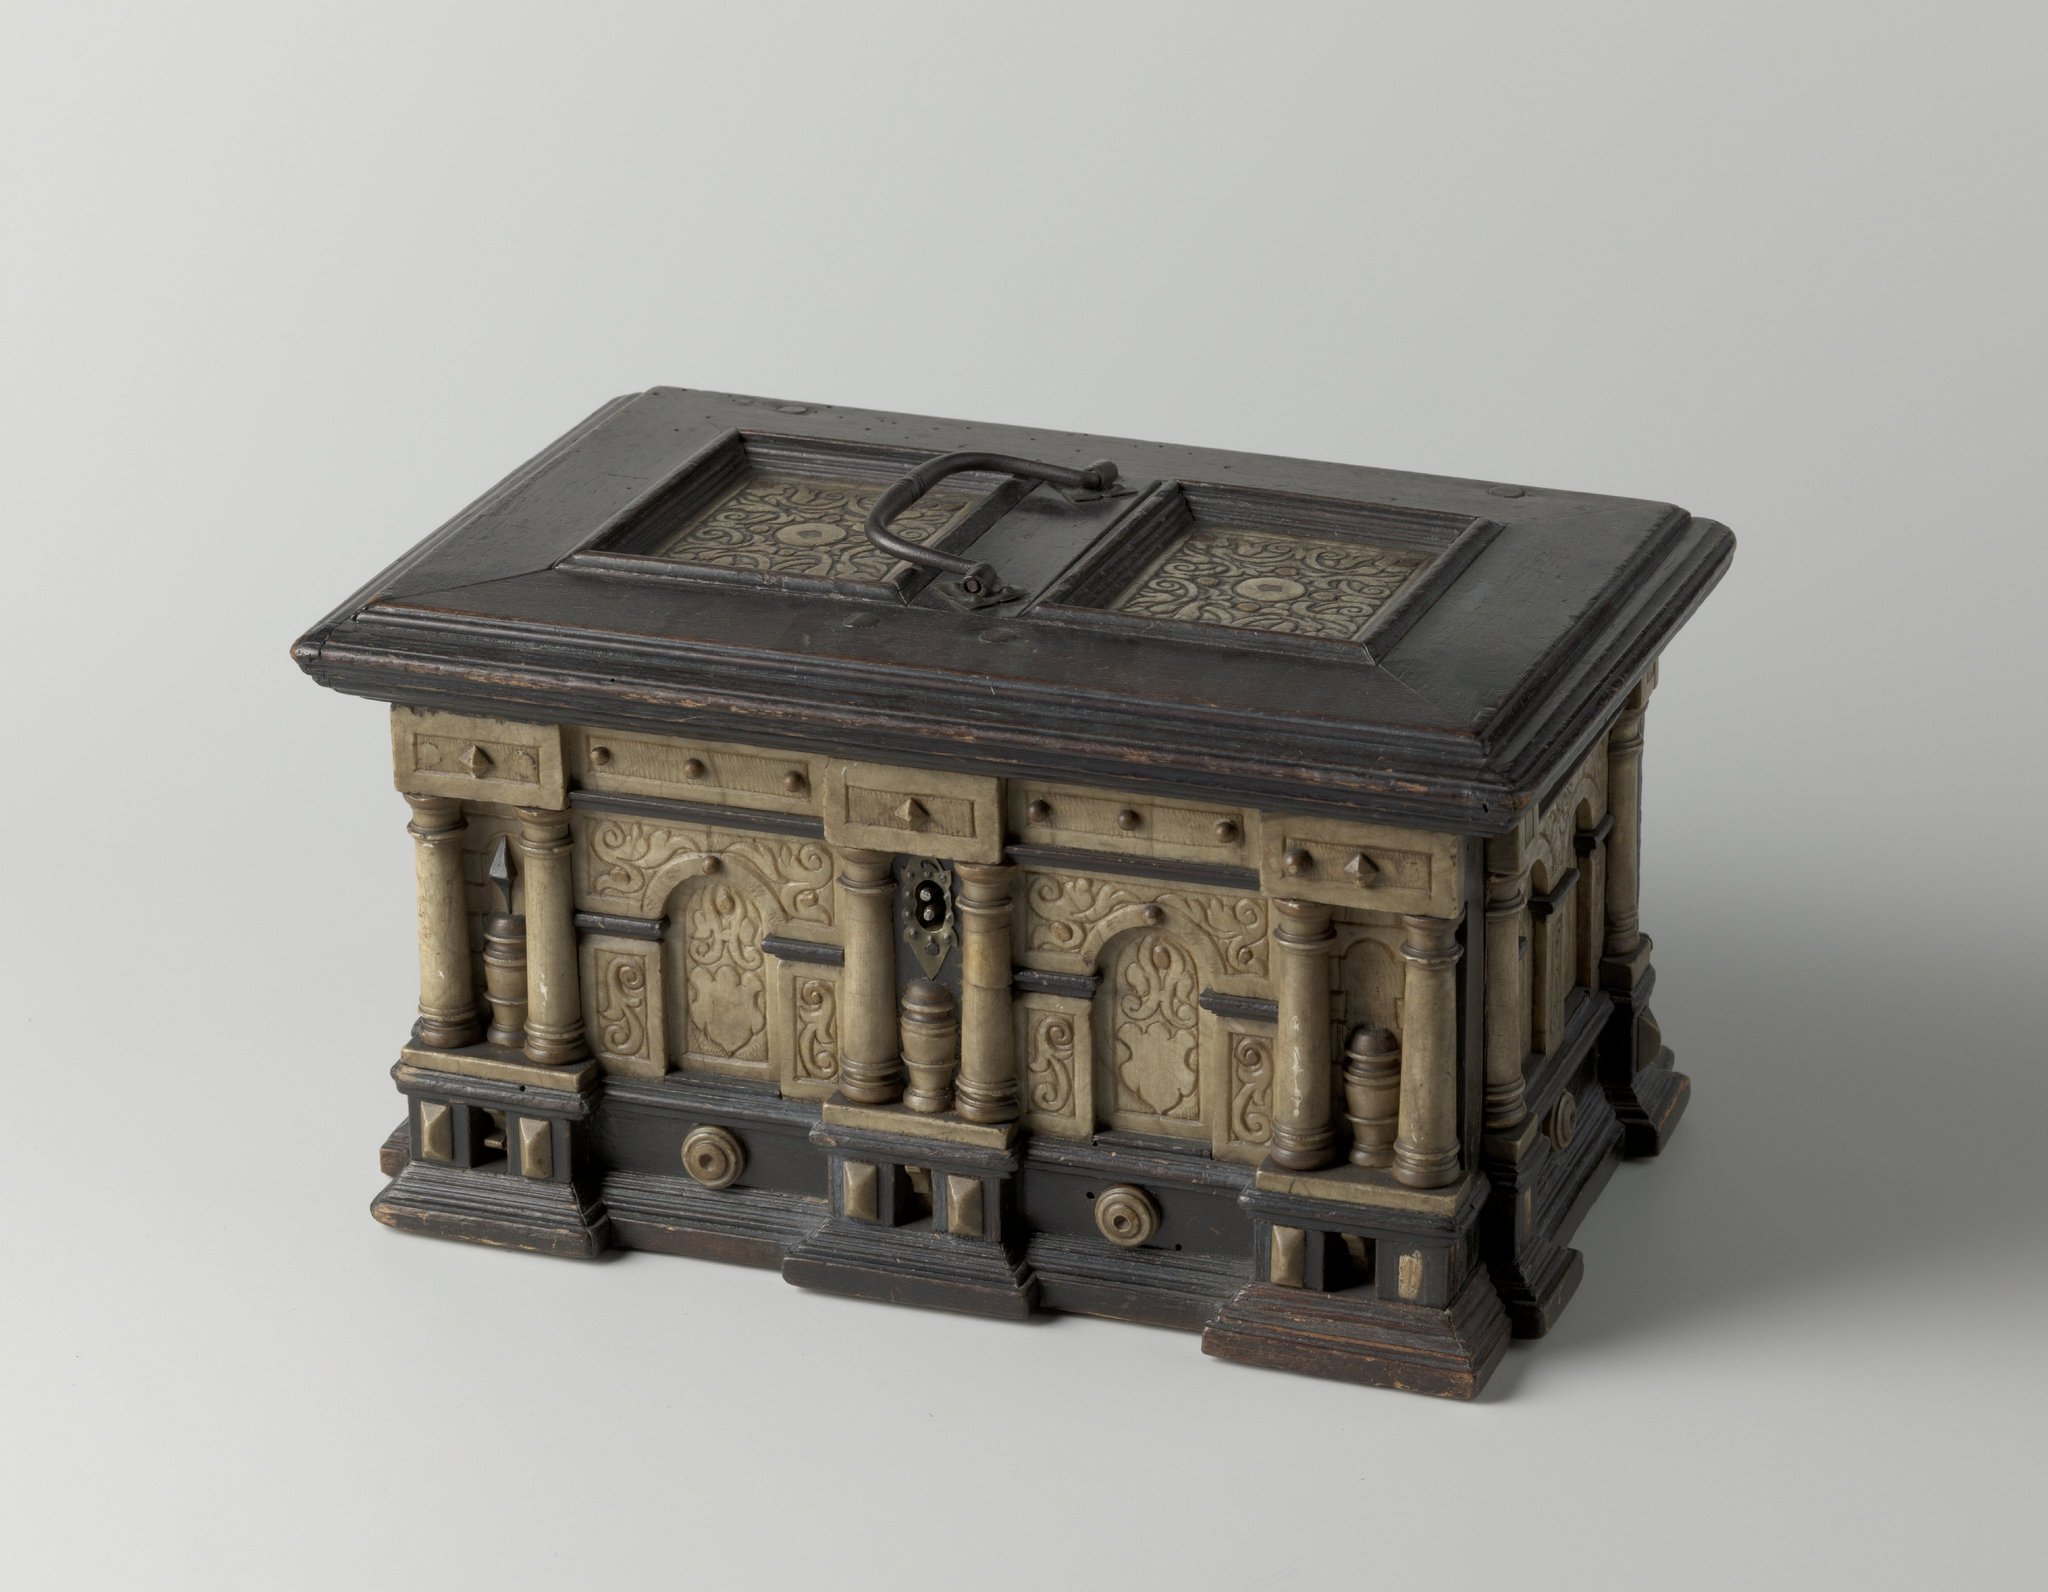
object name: case furniture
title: Kist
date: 1600-1699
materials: bone, paint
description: Bijouteriekist van hout met been. Acht geheime laadjes